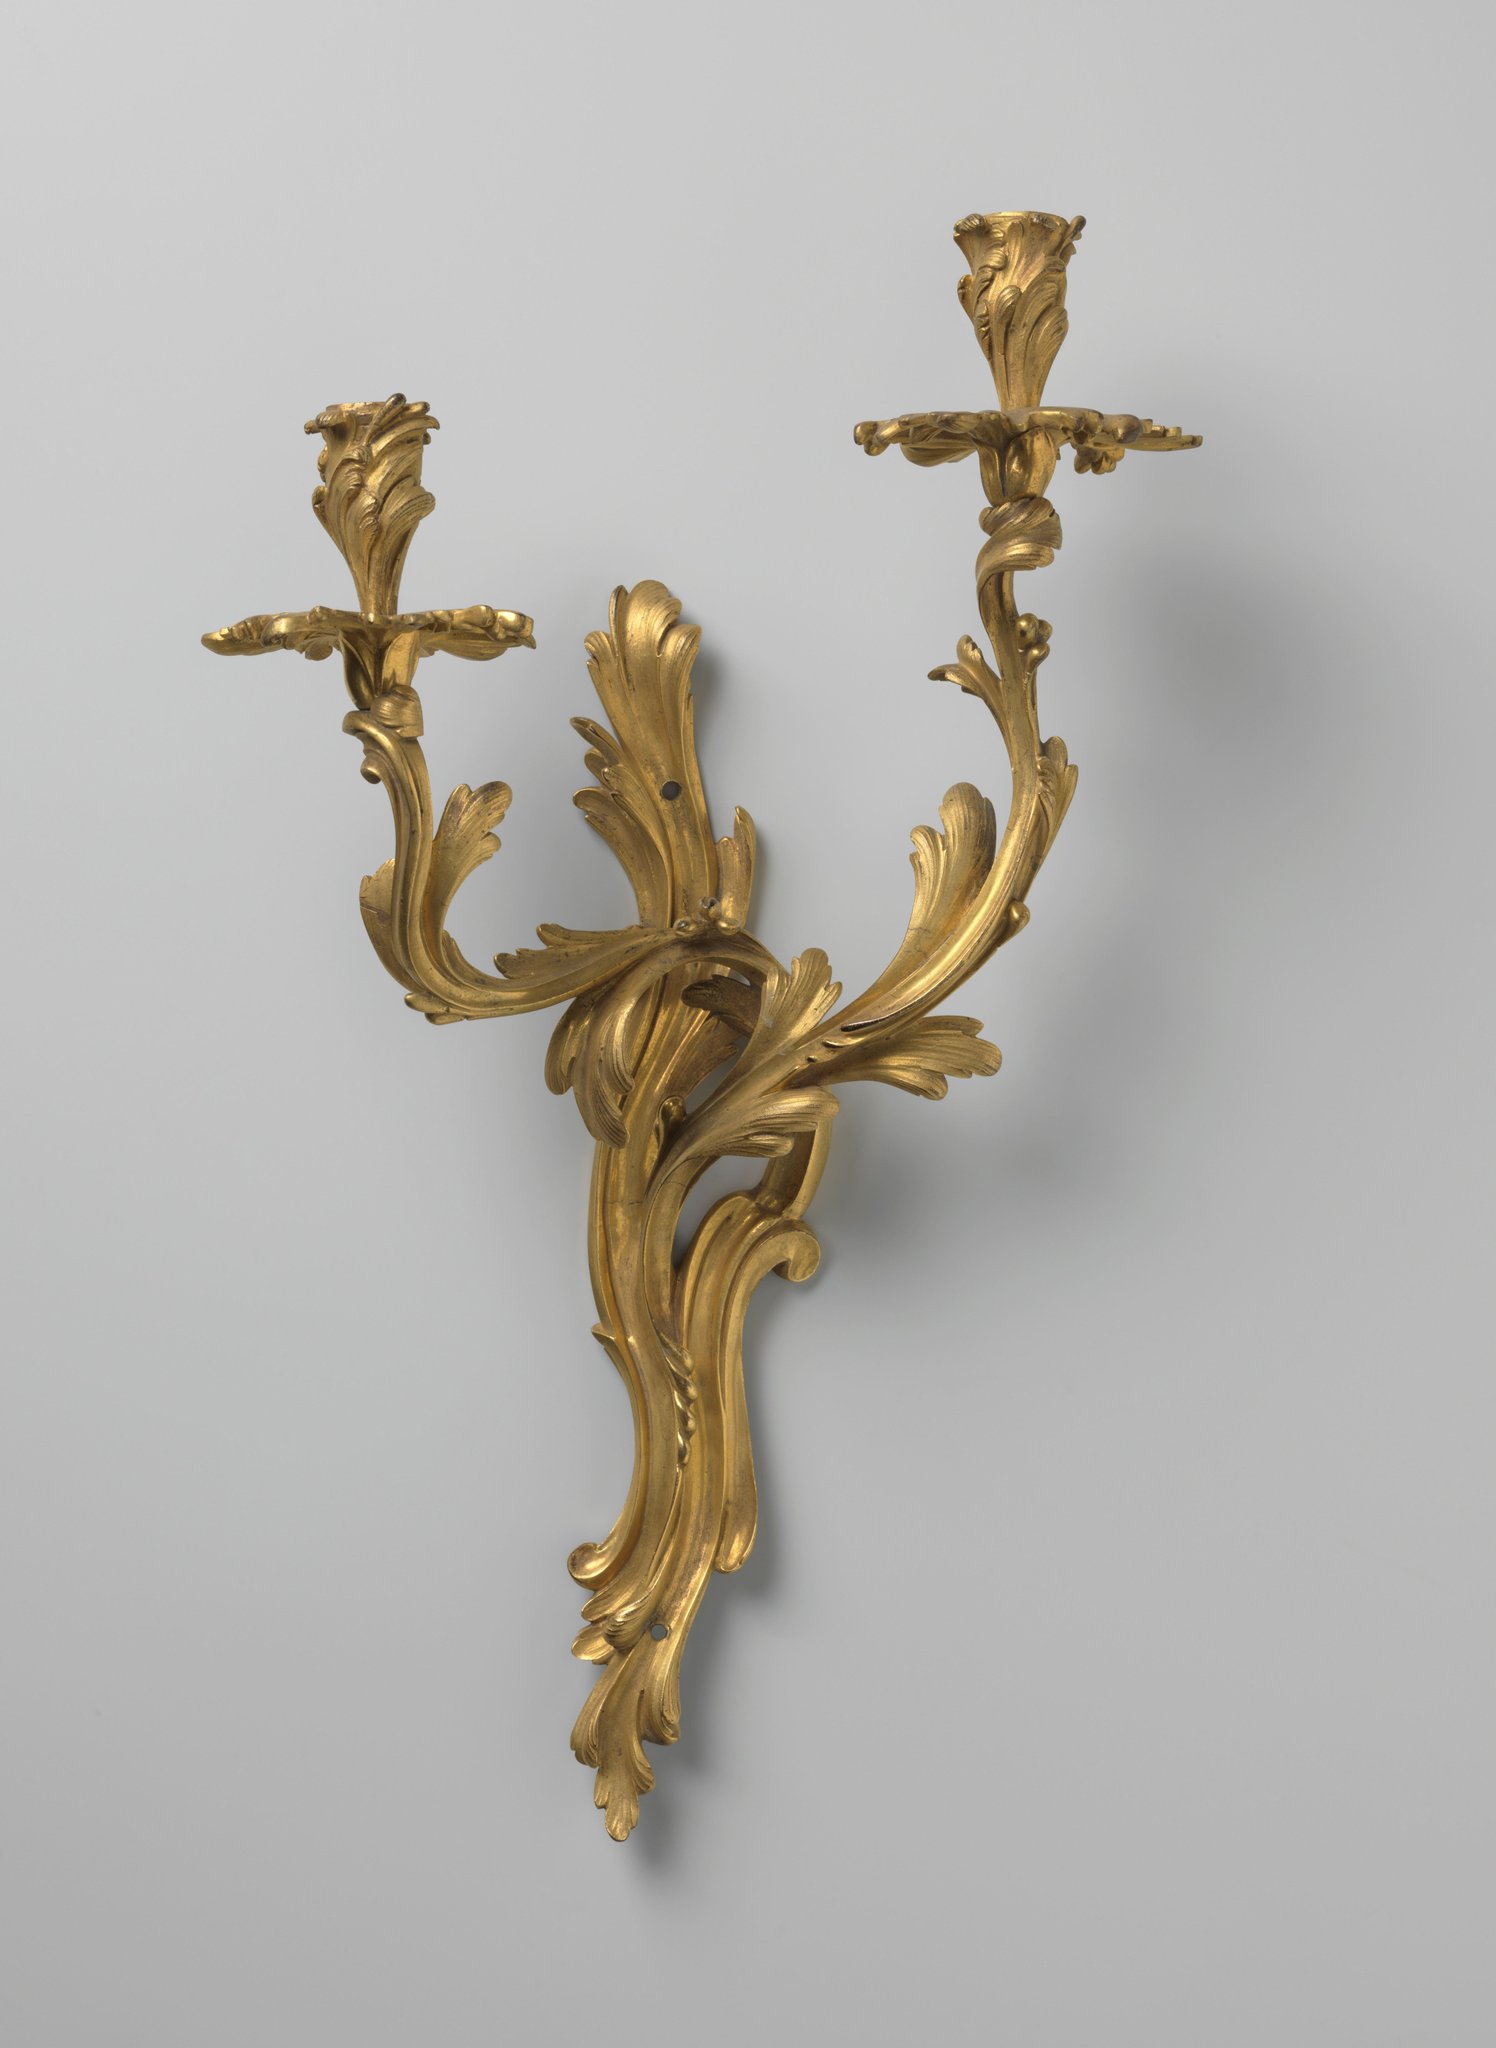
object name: furniture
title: Wandarm van gepolijst koper waarvan de onderdelen zijn opgebouwd uit bladvoluten en bladvormen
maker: Anonymous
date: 1740-1760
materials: copper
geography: france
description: Wandarm van gepolijst koper. De stam is opgebouwd uit bladvoluten, waarvan er twee elkaar bovenaan kruisen en doorlopen in de armen. De vethouders zijn bladvormig en de kaarsenhouders zijn eveneens opgebouwd uit bladvoluten. Zie tevens: BK-14301-b.